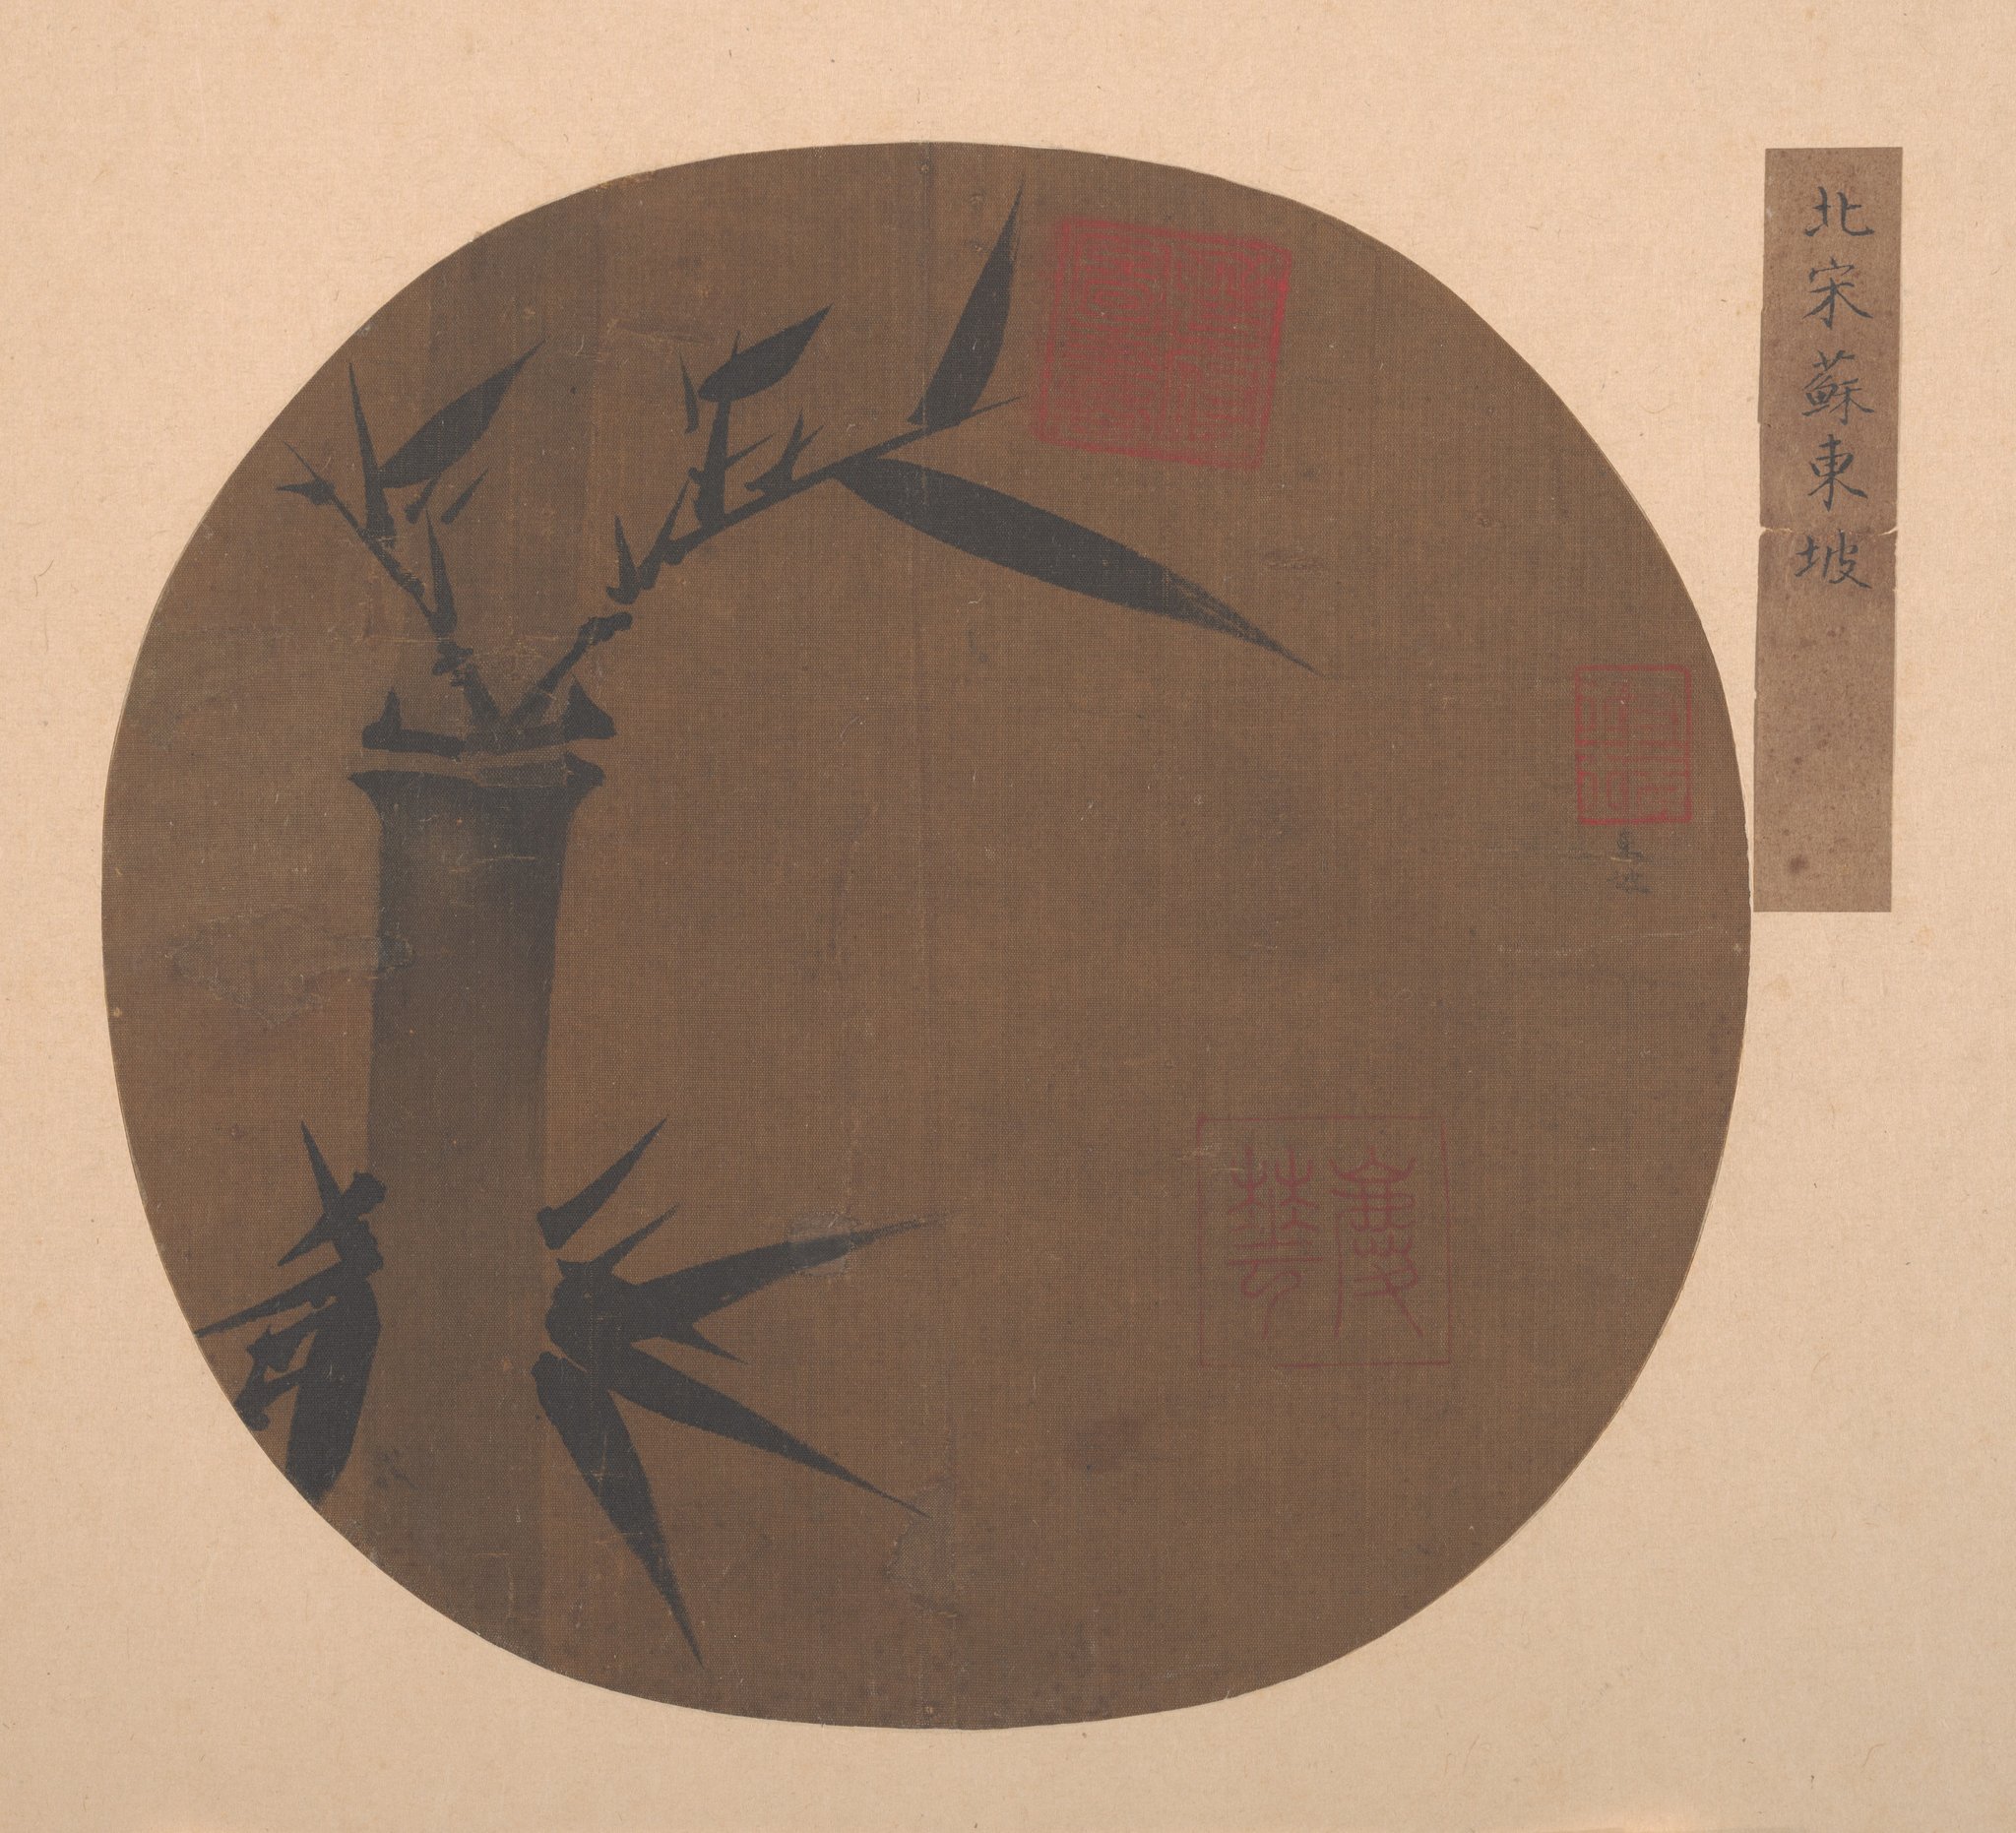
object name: fan mounted a an album leaf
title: Bamboo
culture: chinese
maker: unidentified artist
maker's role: artist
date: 1368-1911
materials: ink, silk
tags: bamboo